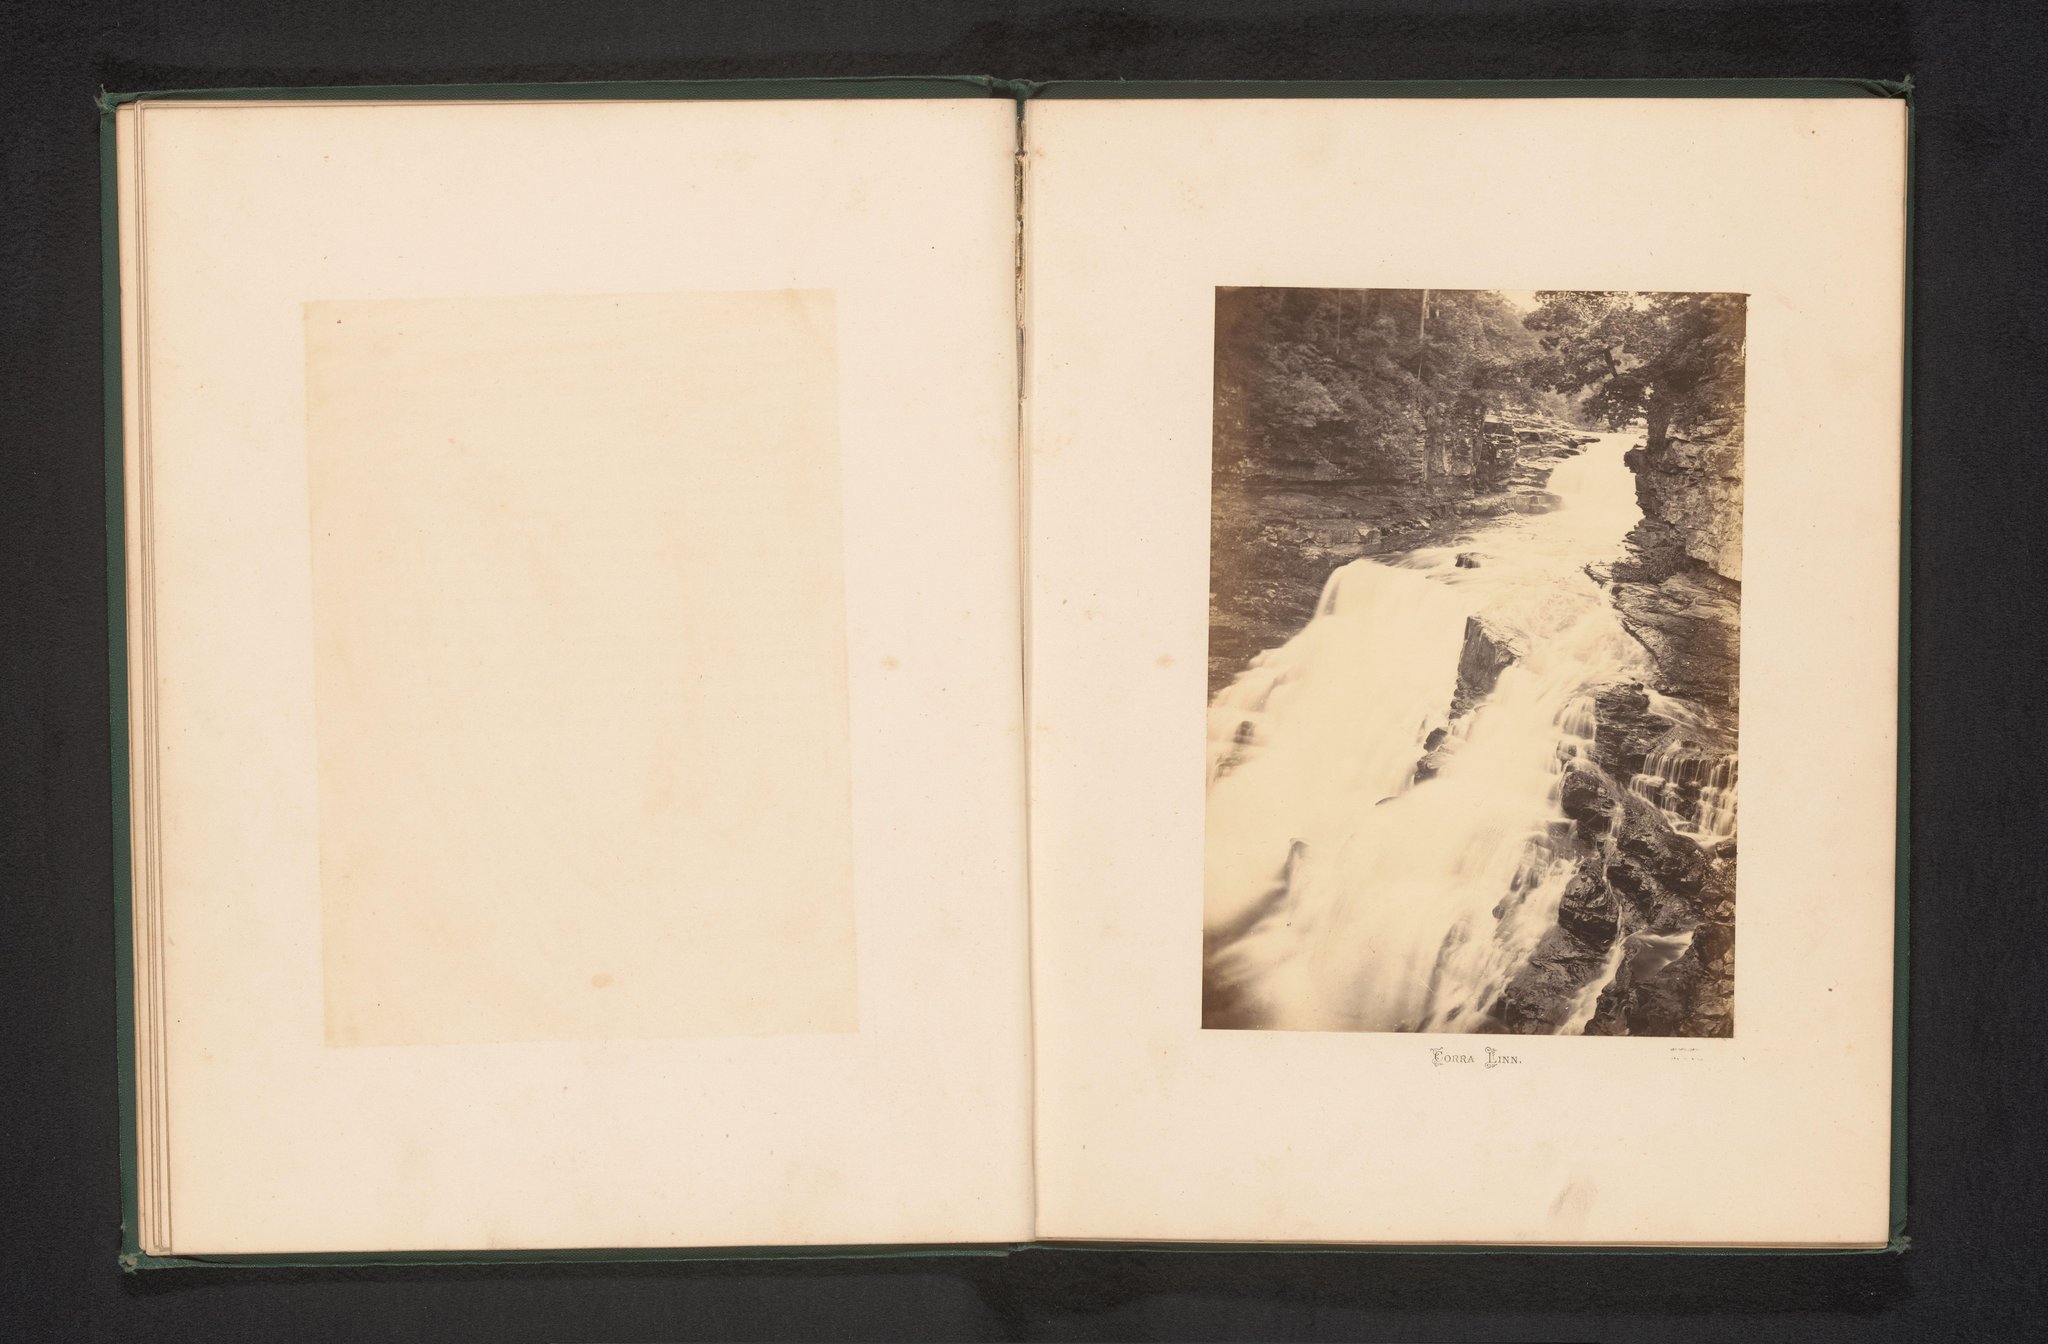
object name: page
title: Gezicht op de waterval Corra Linn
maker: Anonymous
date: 1862-1867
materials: photographic support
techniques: albumen print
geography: south lanarkshire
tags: waterfall, landscapes with waters, waterscapes, seascapes (in the temperate zone)